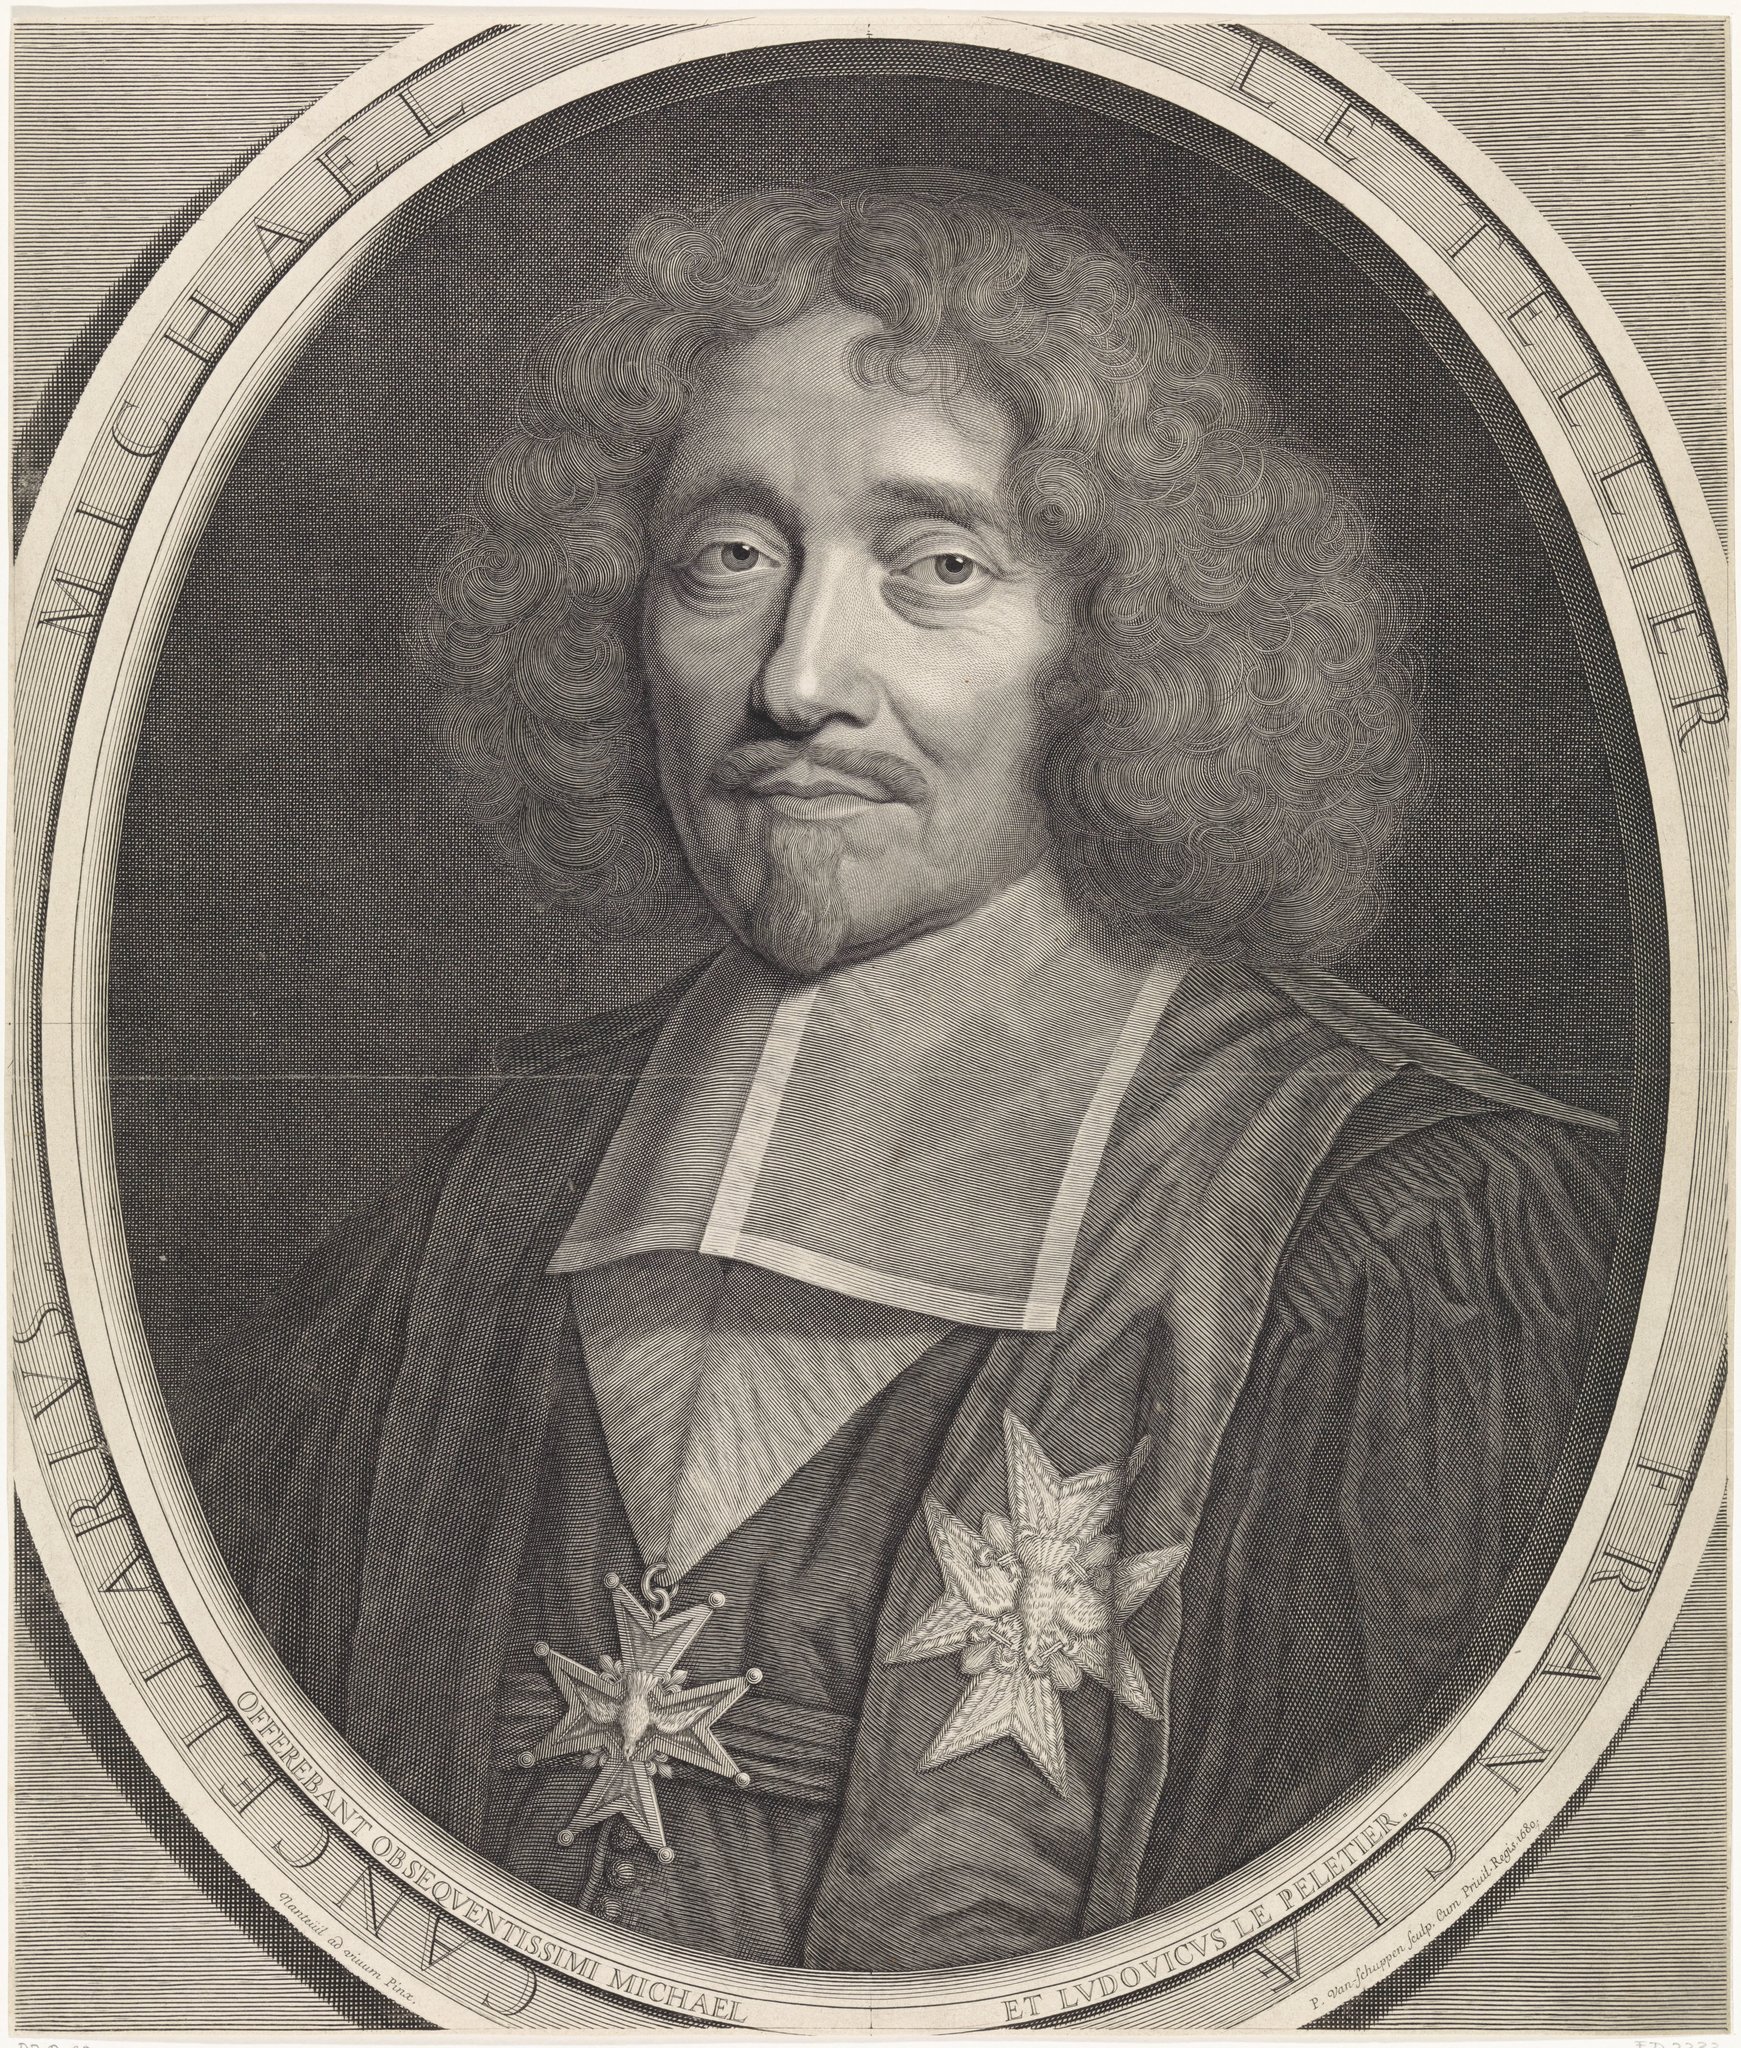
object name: print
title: Portret van Michel Le Tellier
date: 1607-1680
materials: paper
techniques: engraving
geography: paris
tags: paris, michel le tellier, knighthood order of the holy spirit - insignia of a knighthood order, e.g.: badge, chain (with name of order)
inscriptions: collector's mark: Lugt 2228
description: Portret van kanselier Michel Le Tellier. Om zijn hals draagt hij het kruis van de Orde van de Heilige Geest. Ook zijn jas is, in borduursel, voorzien van hetzelfde ordeteken.